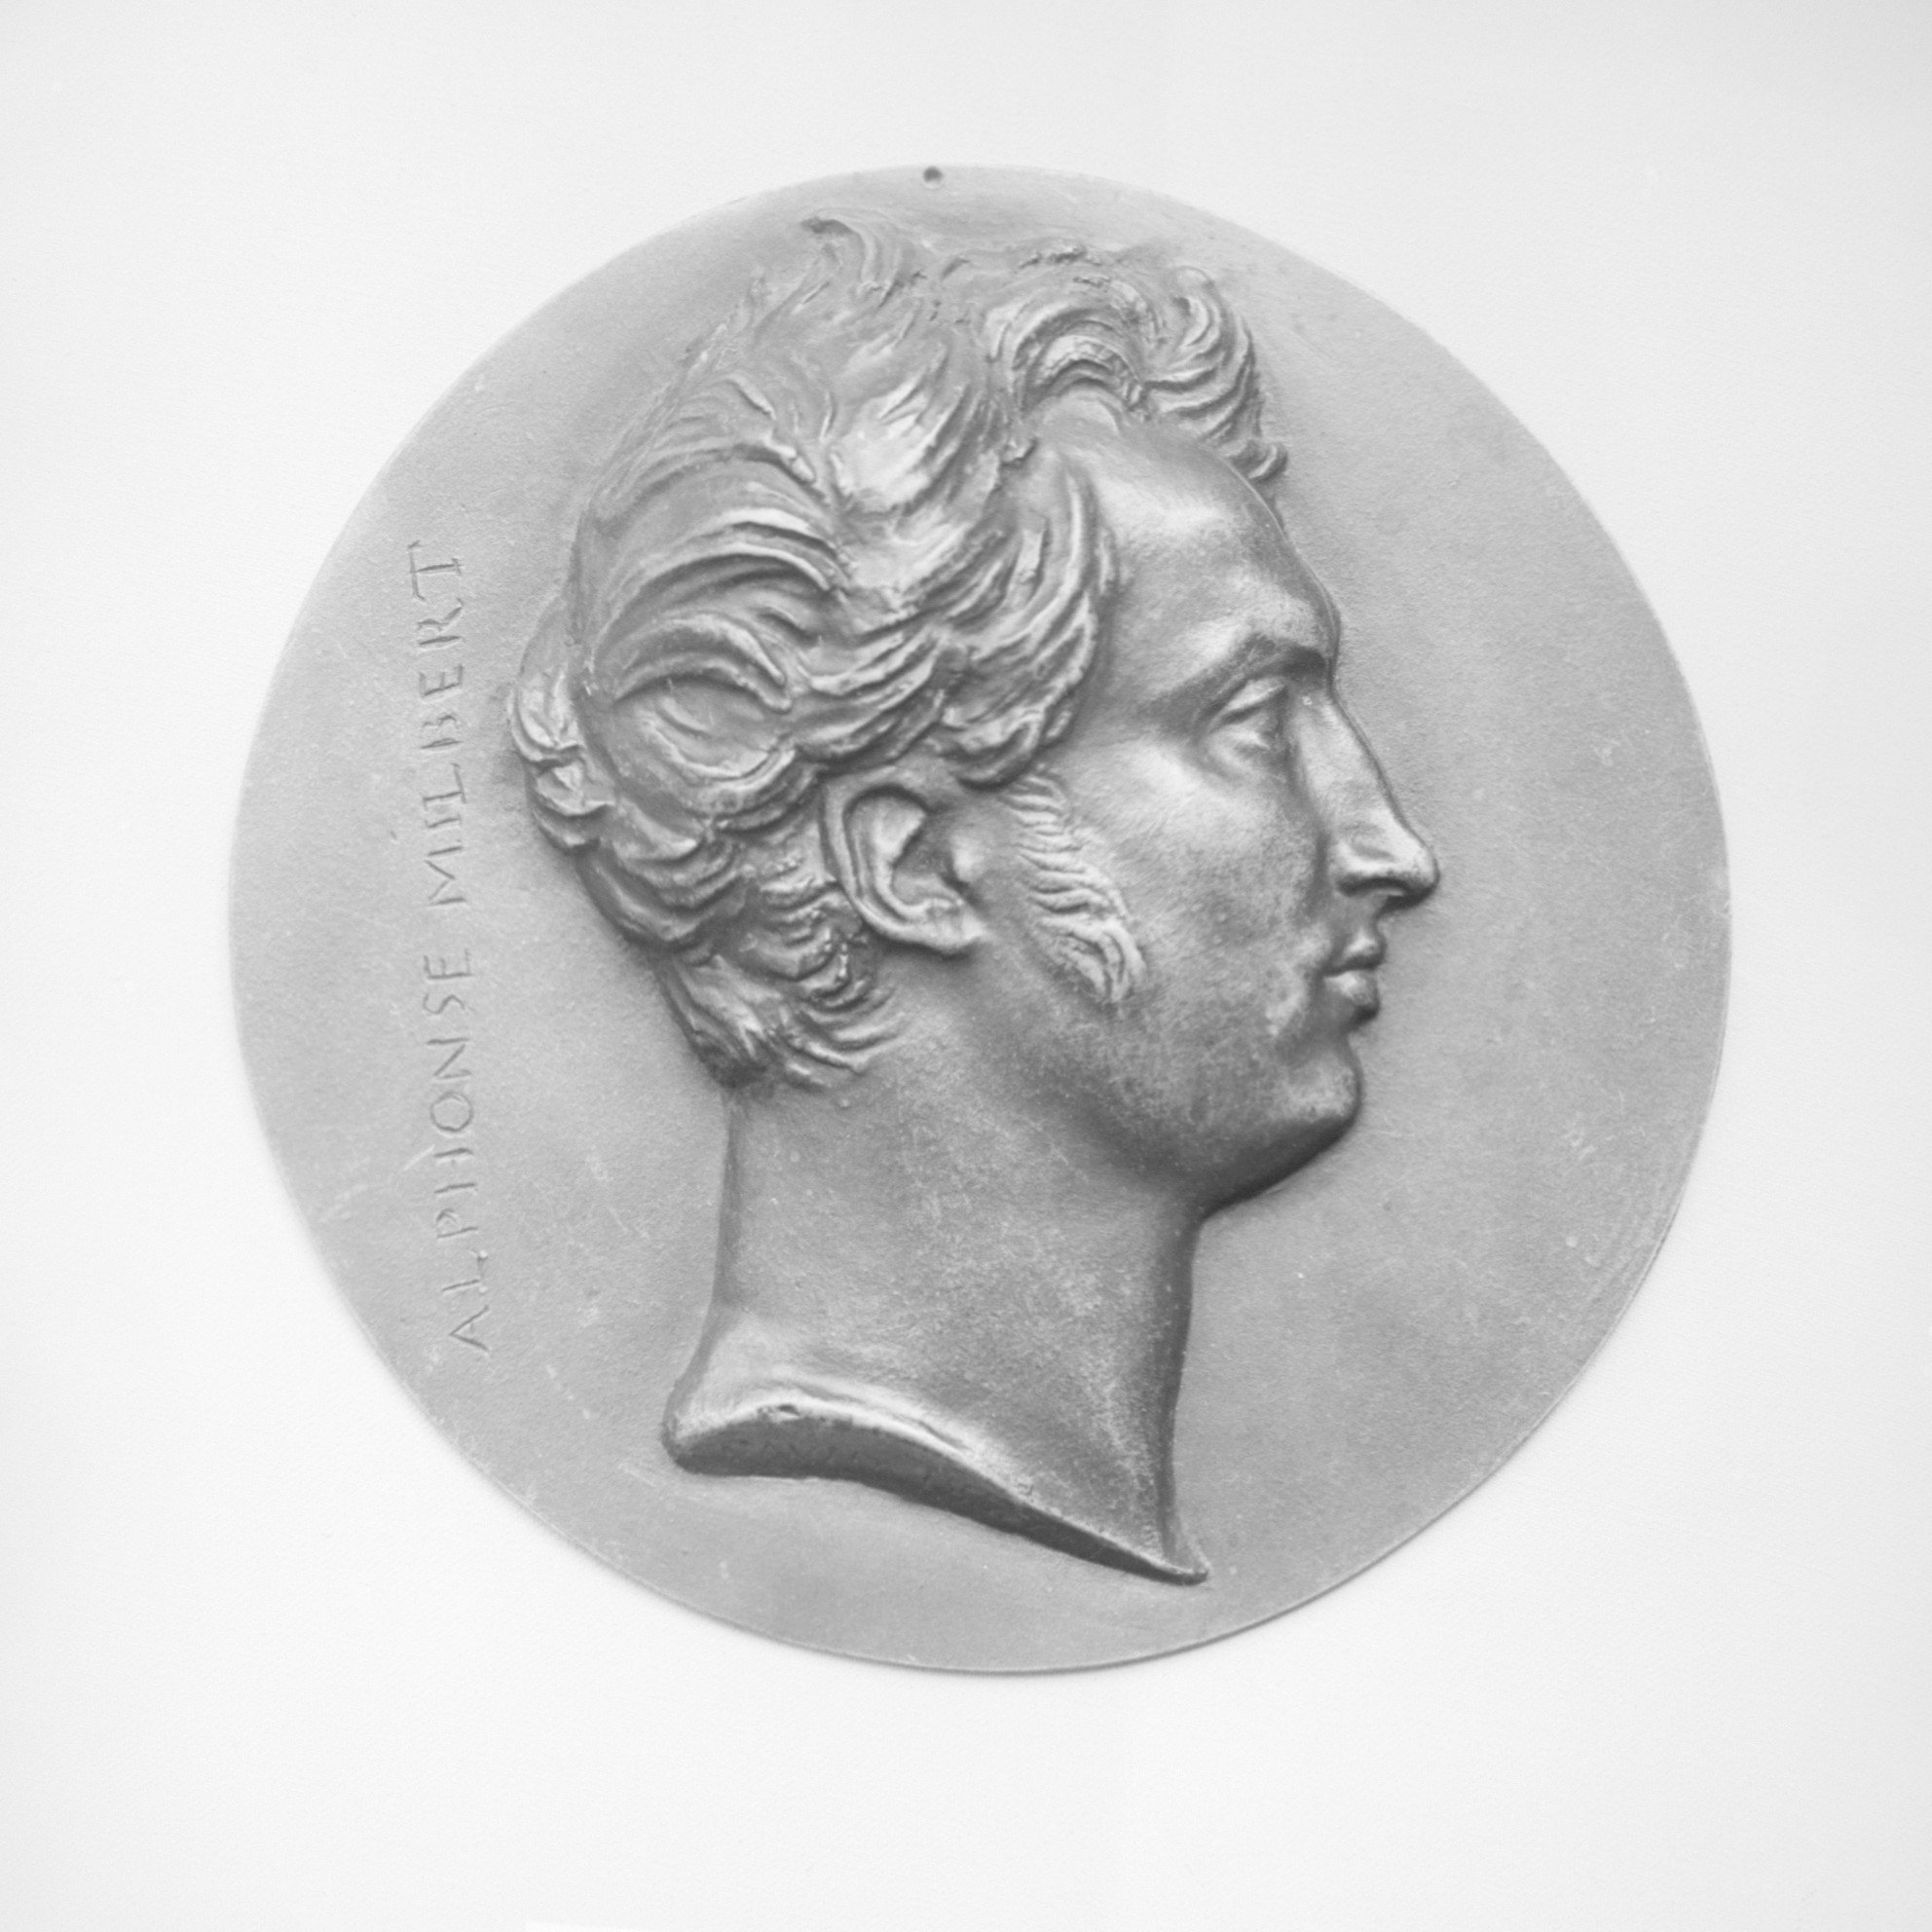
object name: medallion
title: Alphonse Milbert, Advocate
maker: pierre jean david d'angers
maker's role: artist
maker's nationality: french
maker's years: 1788-1856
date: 1838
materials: bronze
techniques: casting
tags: men,profiles